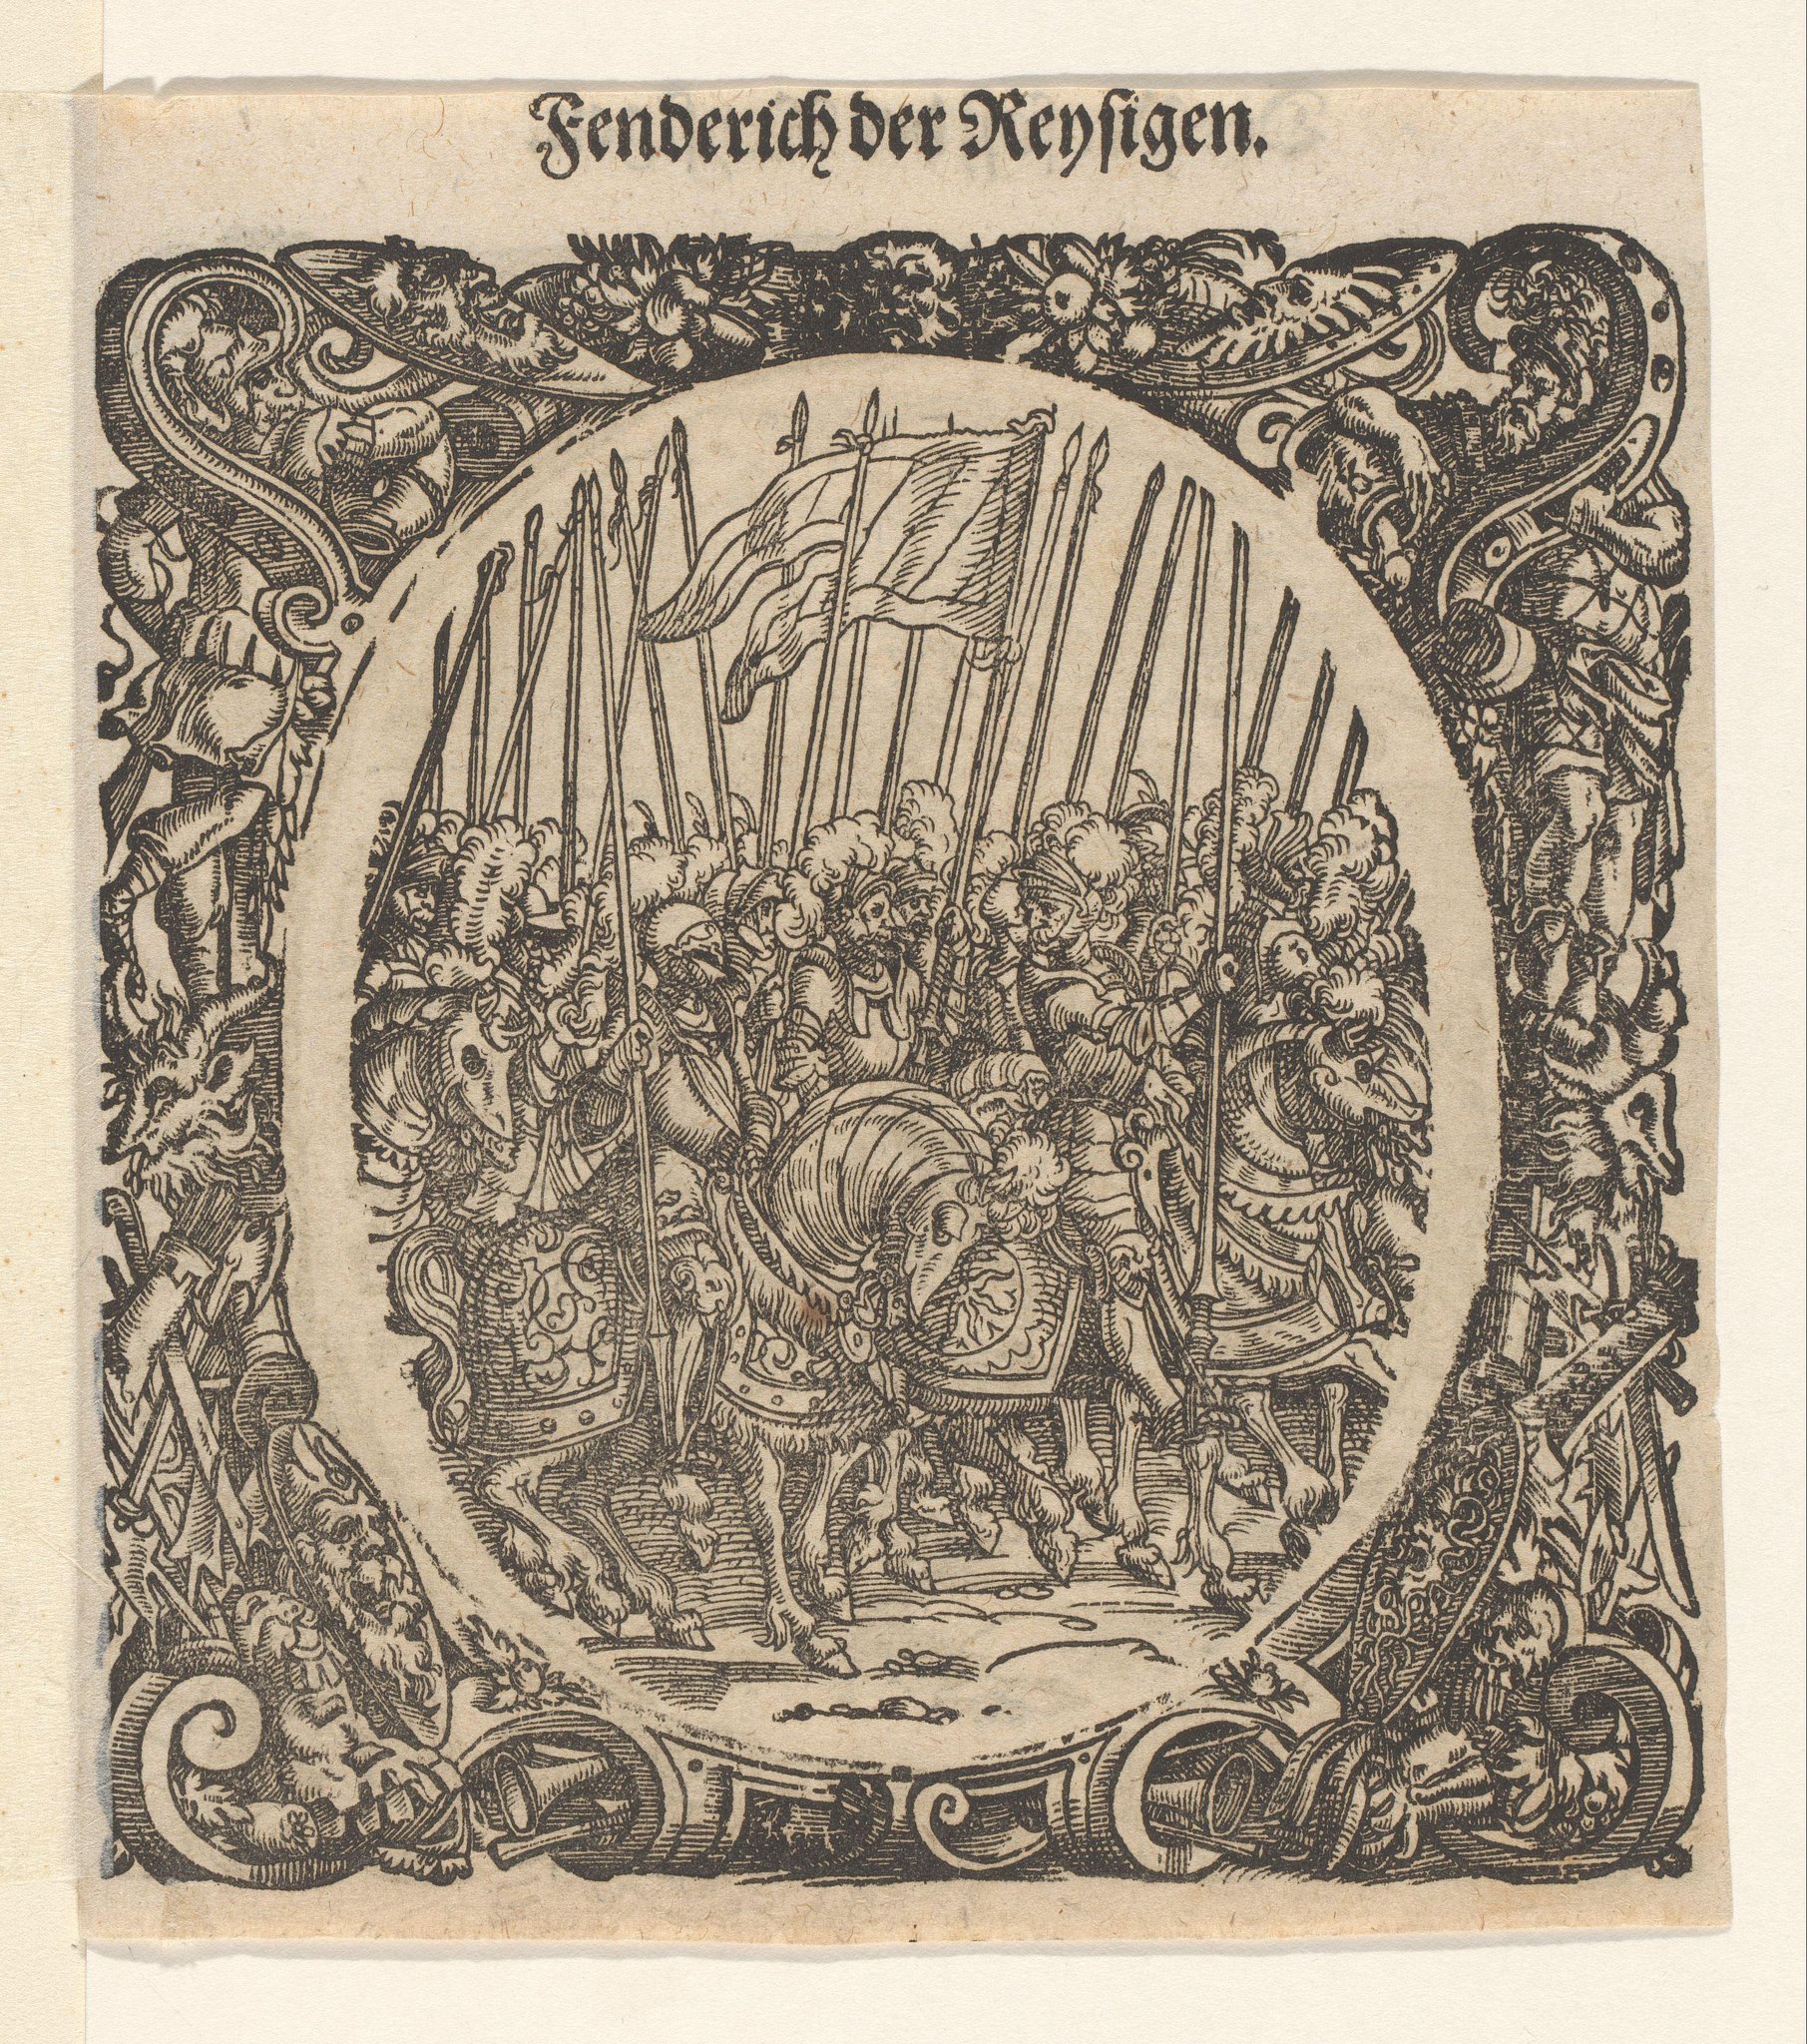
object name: book illustration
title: Fenderich der Rensigen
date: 1573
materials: paper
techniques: woodcut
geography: nuremberg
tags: (military) standard-bearer, warfare; military affairs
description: Zowel de voorstelling als de ornamentrand werd gebruikt voor verschillende edities van Leonhardt Fronspergers Kriegsbuch.